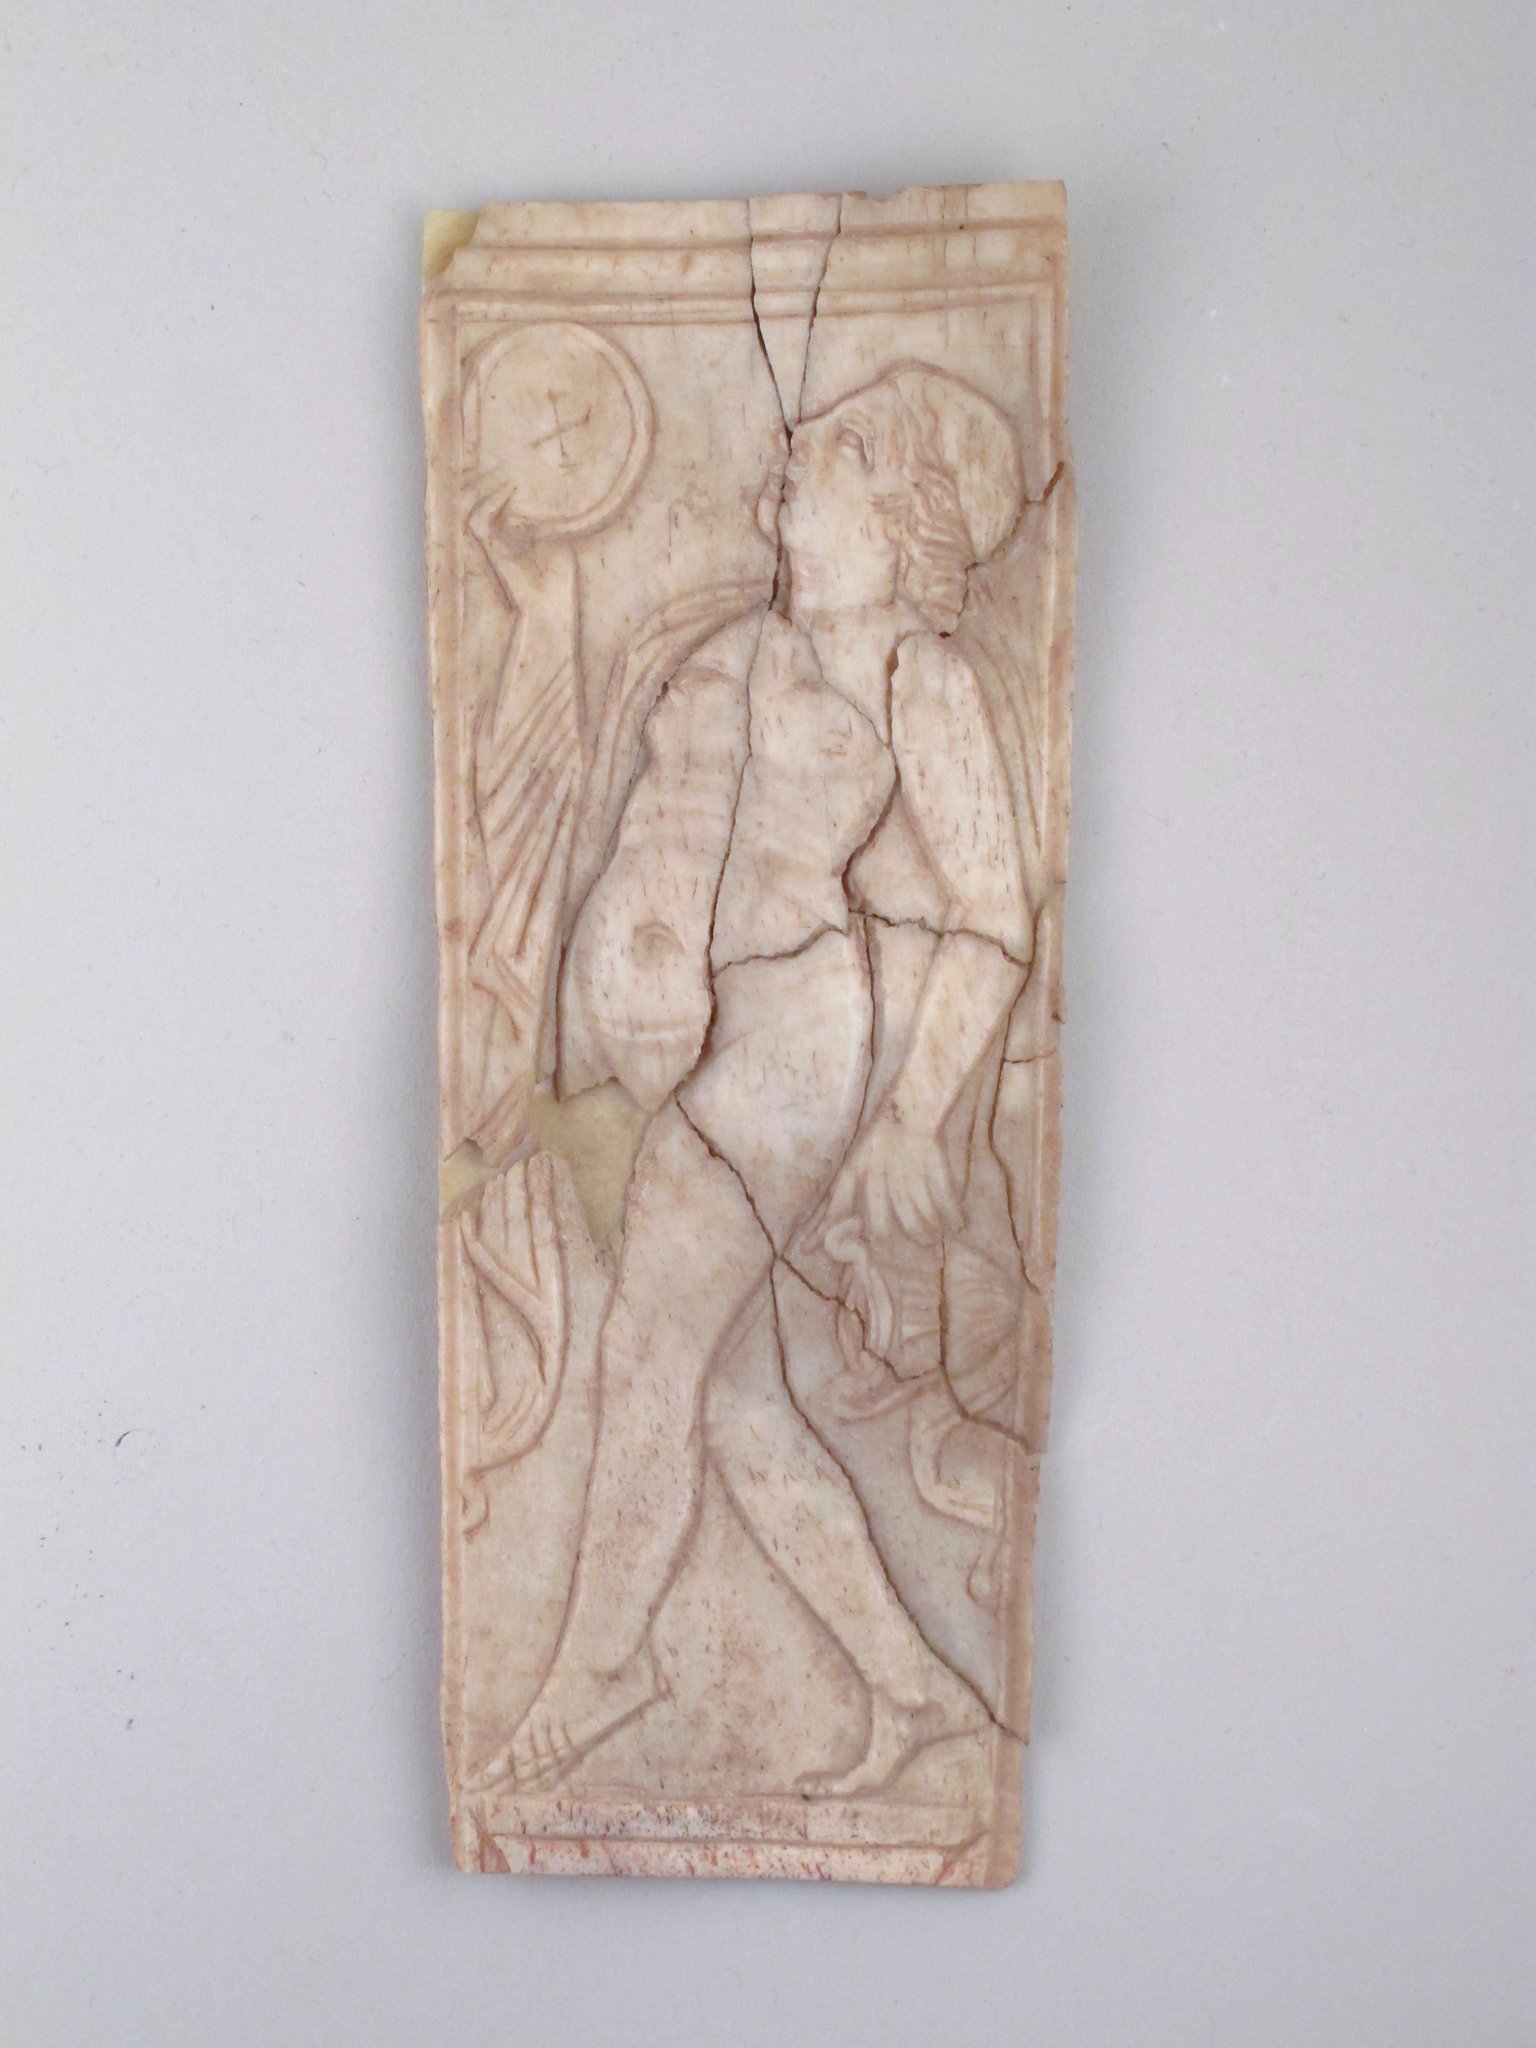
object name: casket plaque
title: Plaque from casket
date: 7000 BCE-330 CE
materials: ivory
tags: maenads